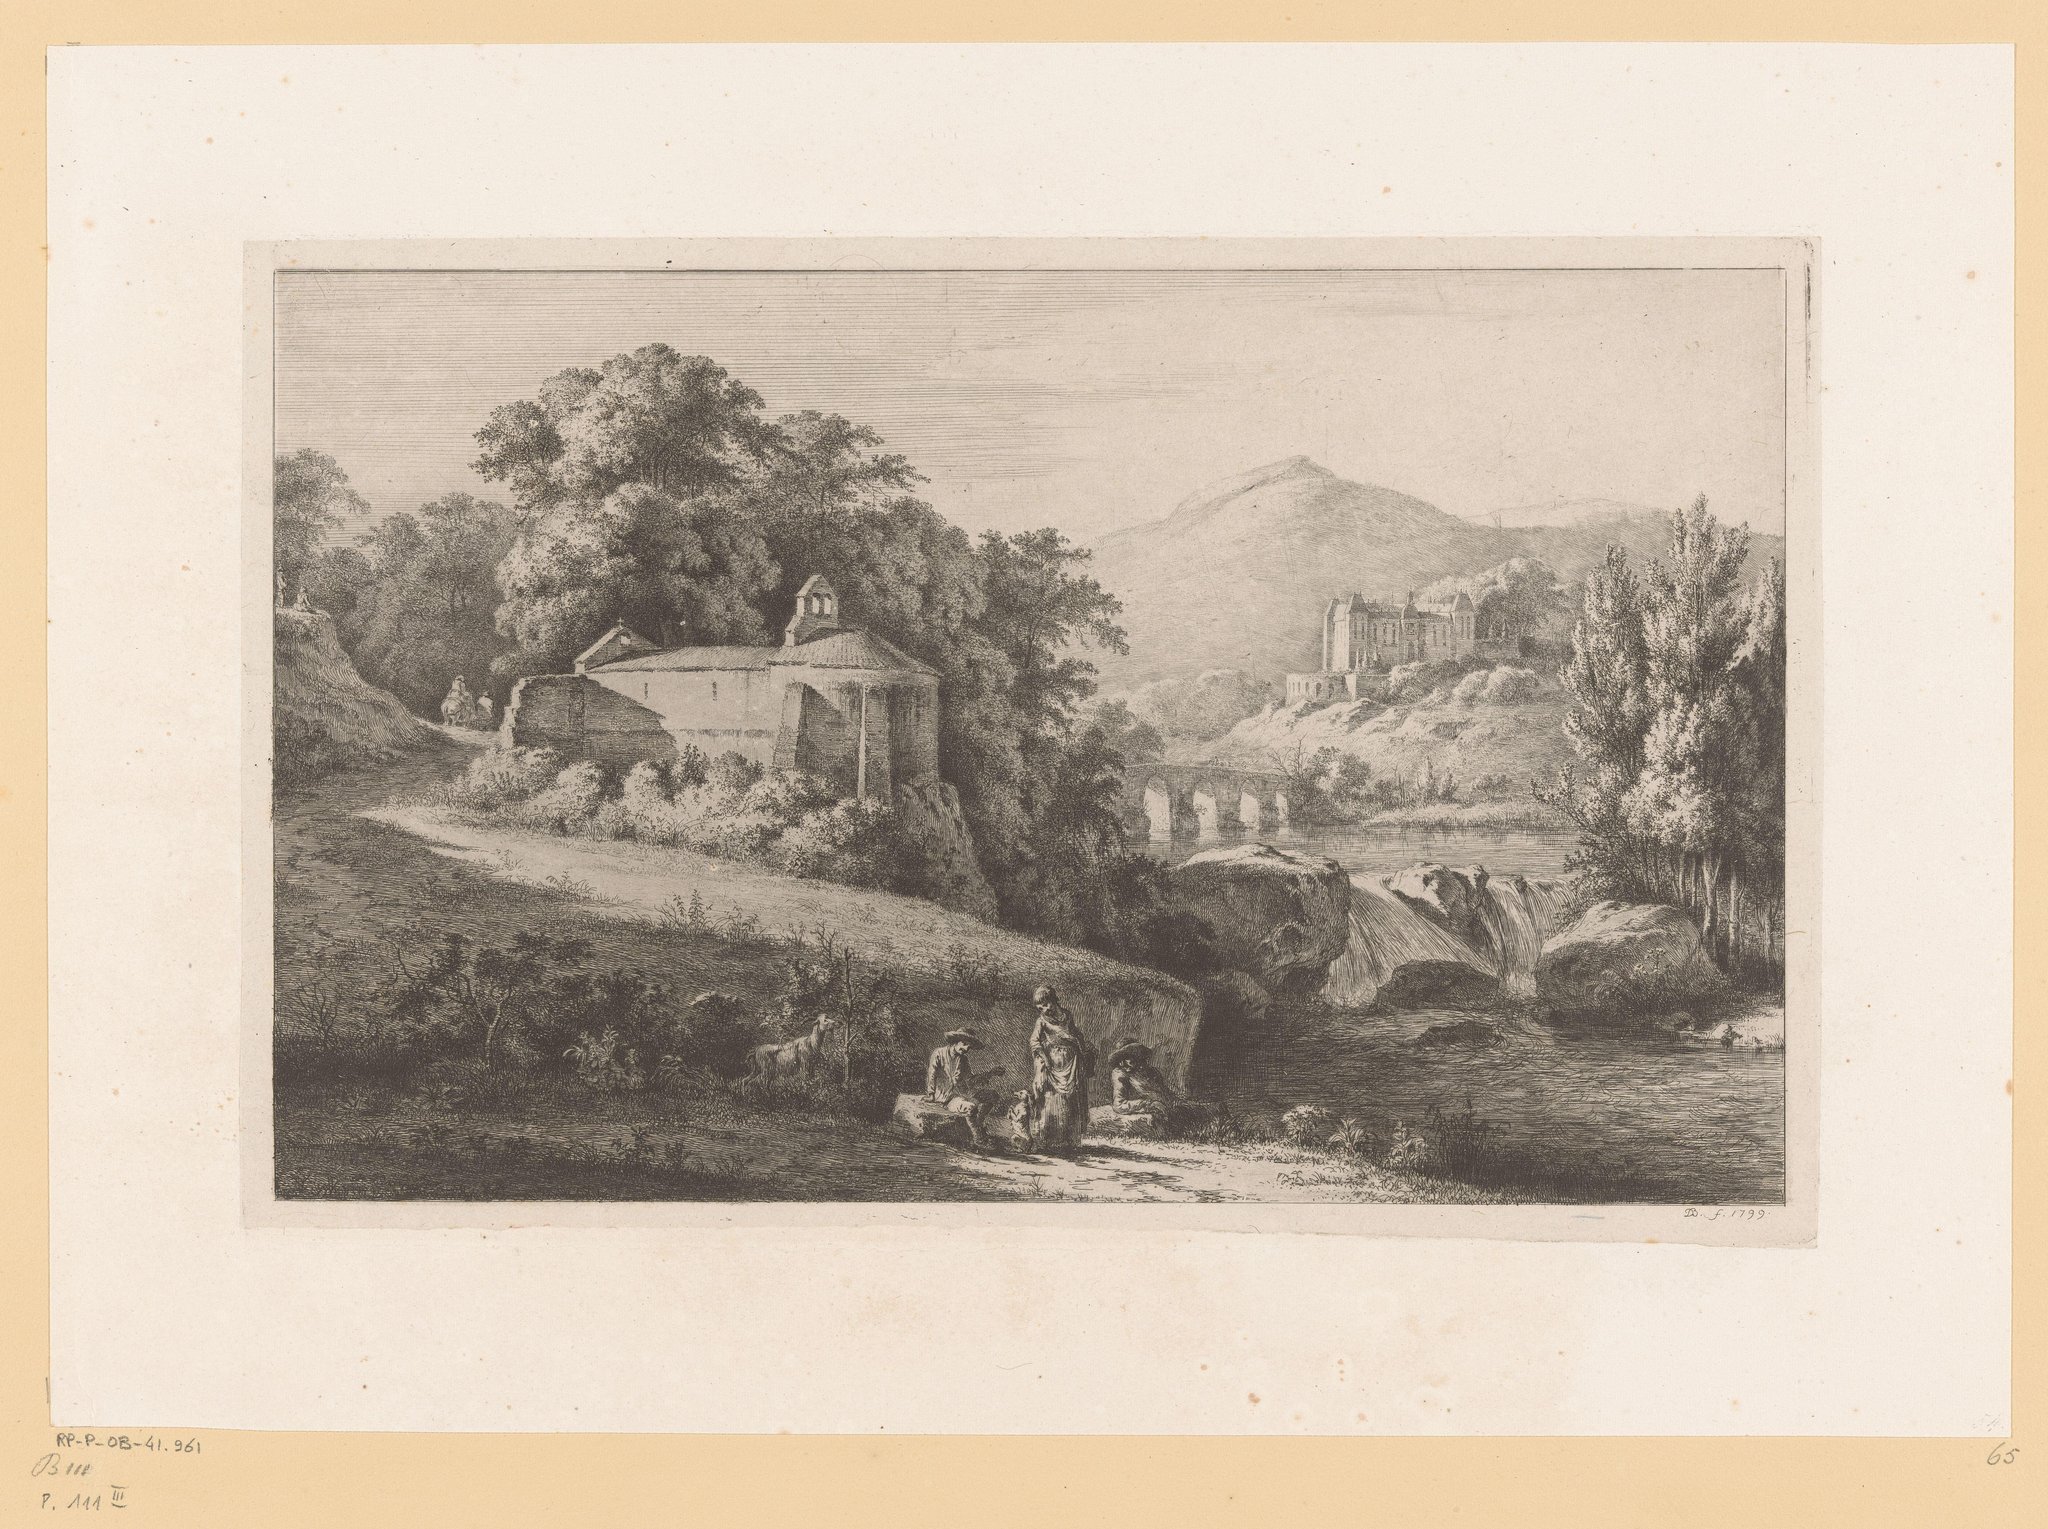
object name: print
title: Rivierlandschap met kerk te Châtillon-d'Azergues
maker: jean jacques de boissieu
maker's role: draughtsman, print maker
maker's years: 1736-1810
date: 1799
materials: paper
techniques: drypoint, etching, roulette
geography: france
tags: landscapes with waters, waterscapes, seascapes (in the temperate zone), landscape with tower or castle, bridge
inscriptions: collector's mark: Lugt 12